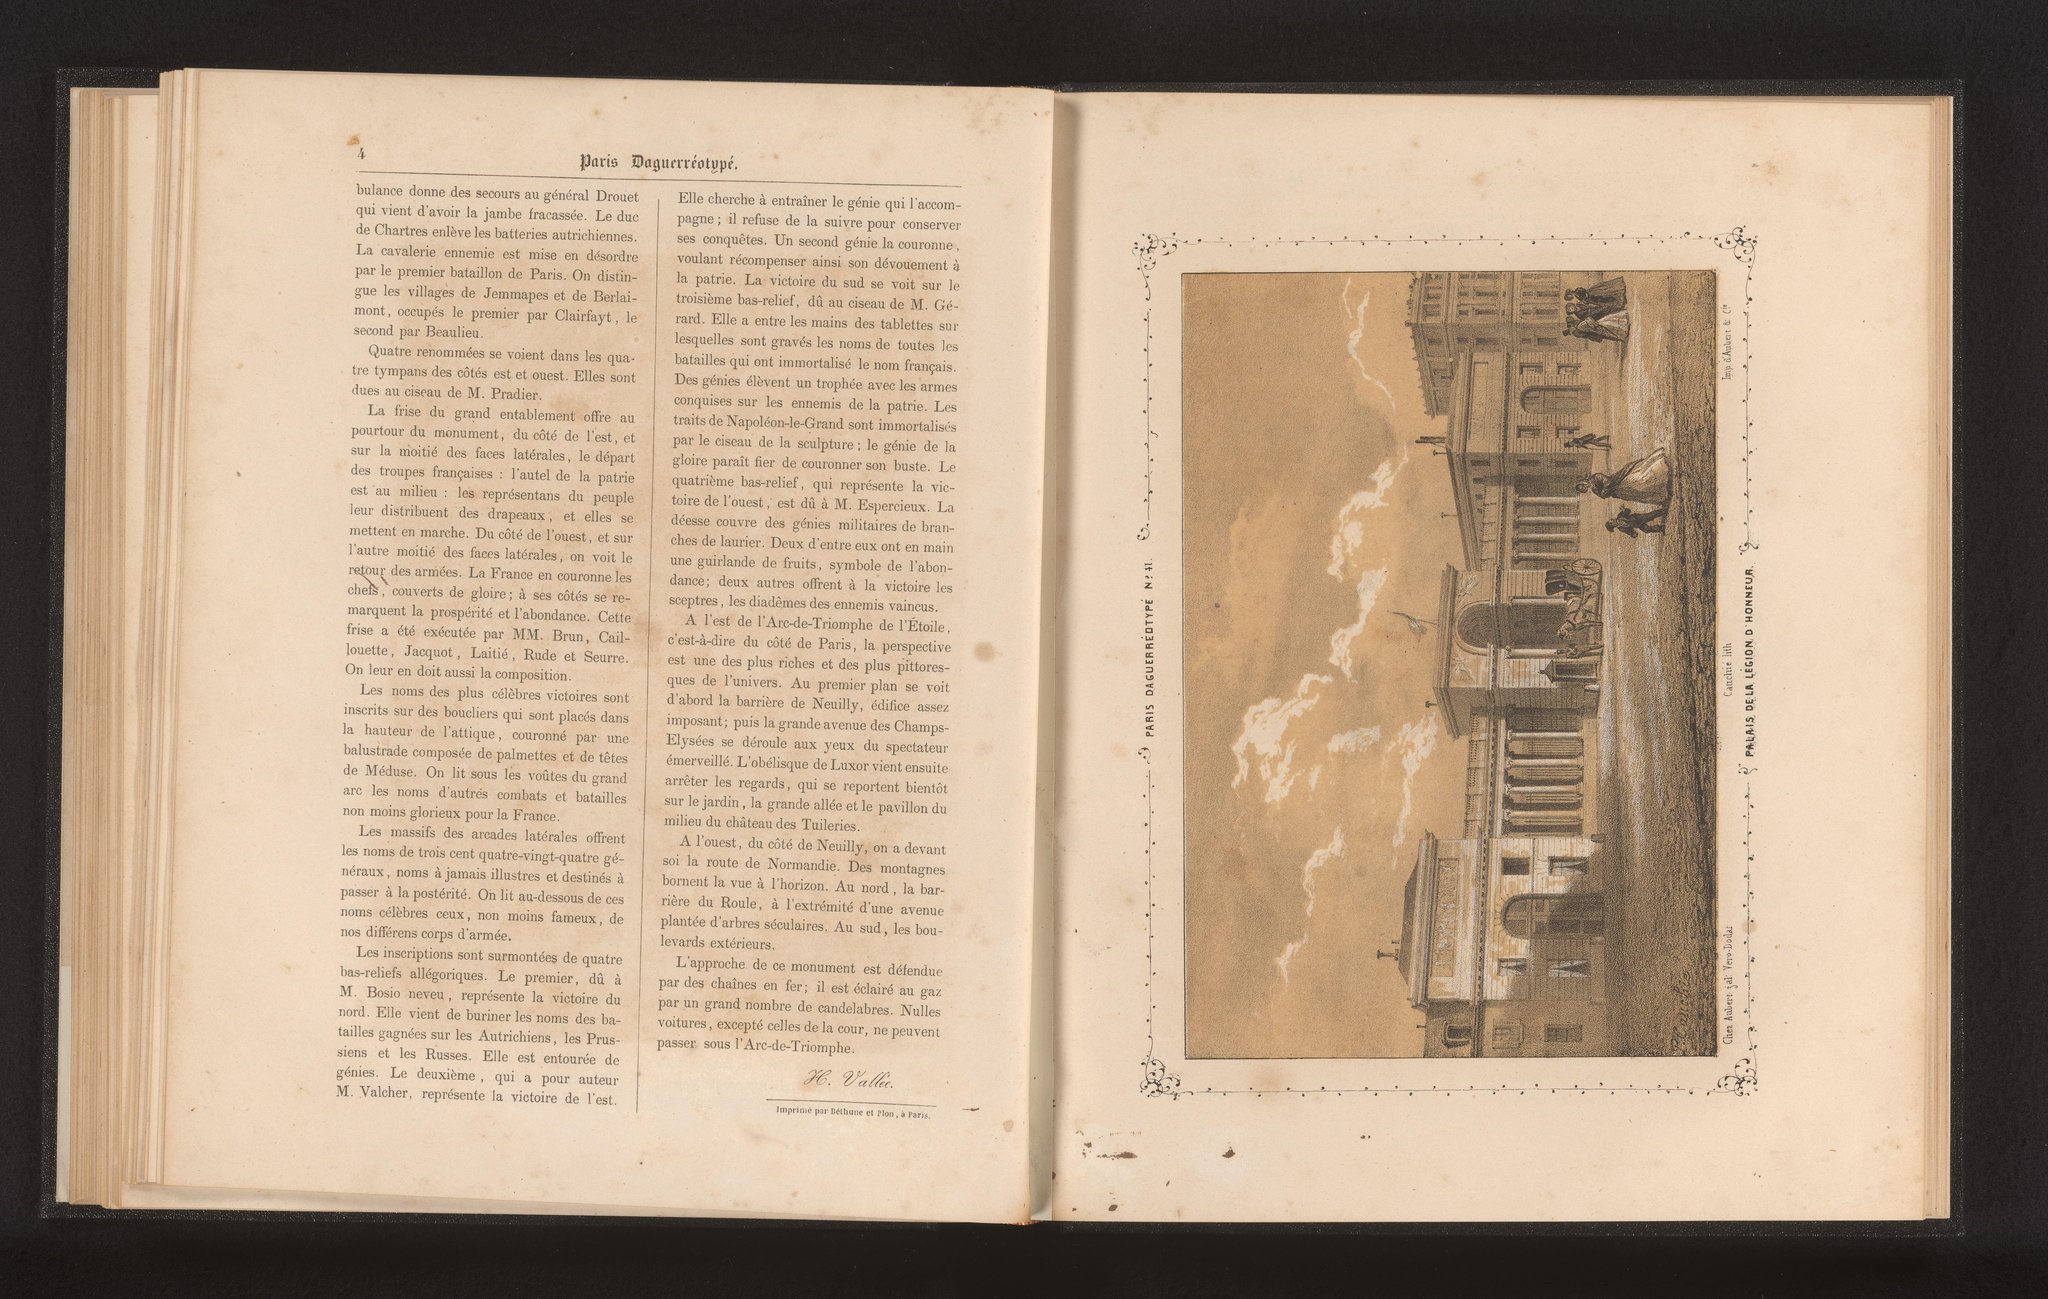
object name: page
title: Palais de la Légion d'honneur in Parijs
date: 1839-1840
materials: paper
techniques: tone lithography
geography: paris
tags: palace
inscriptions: inscription: ‘PARIS DAGUERRÉOTYPÉ No. 41.’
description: Prent op honderddrieënzestigste ongenummerde pagina.